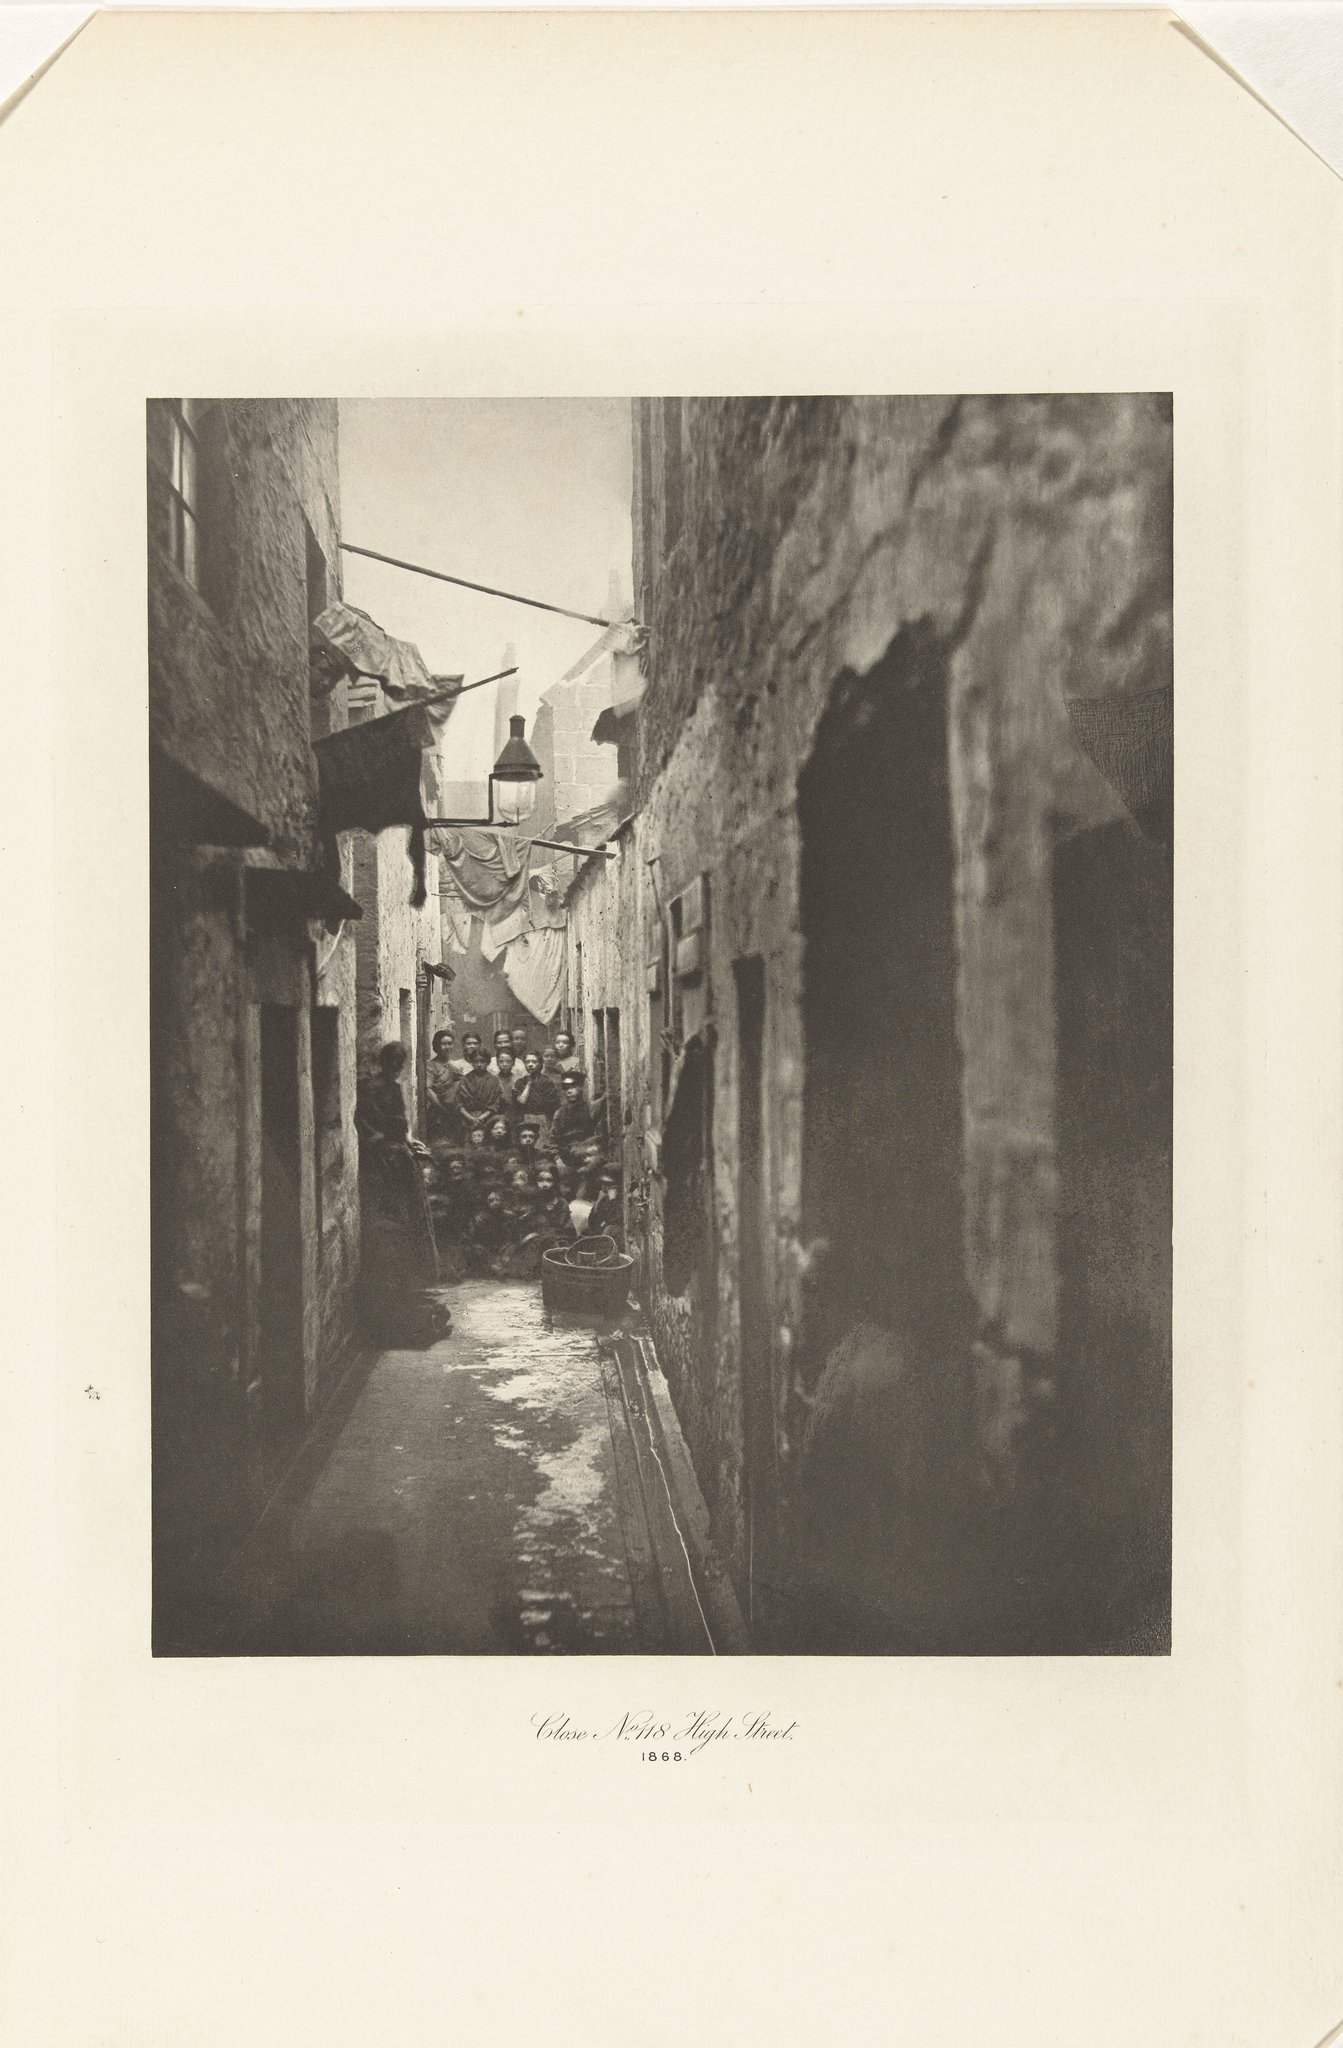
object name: photomechanical print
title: Close, No. 118 High Street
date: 1900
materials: paper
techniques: photoaquatint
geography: glasgow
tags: lane, alley, anonymous historical persons portrayed in a group, in a group-portrait, glasgow